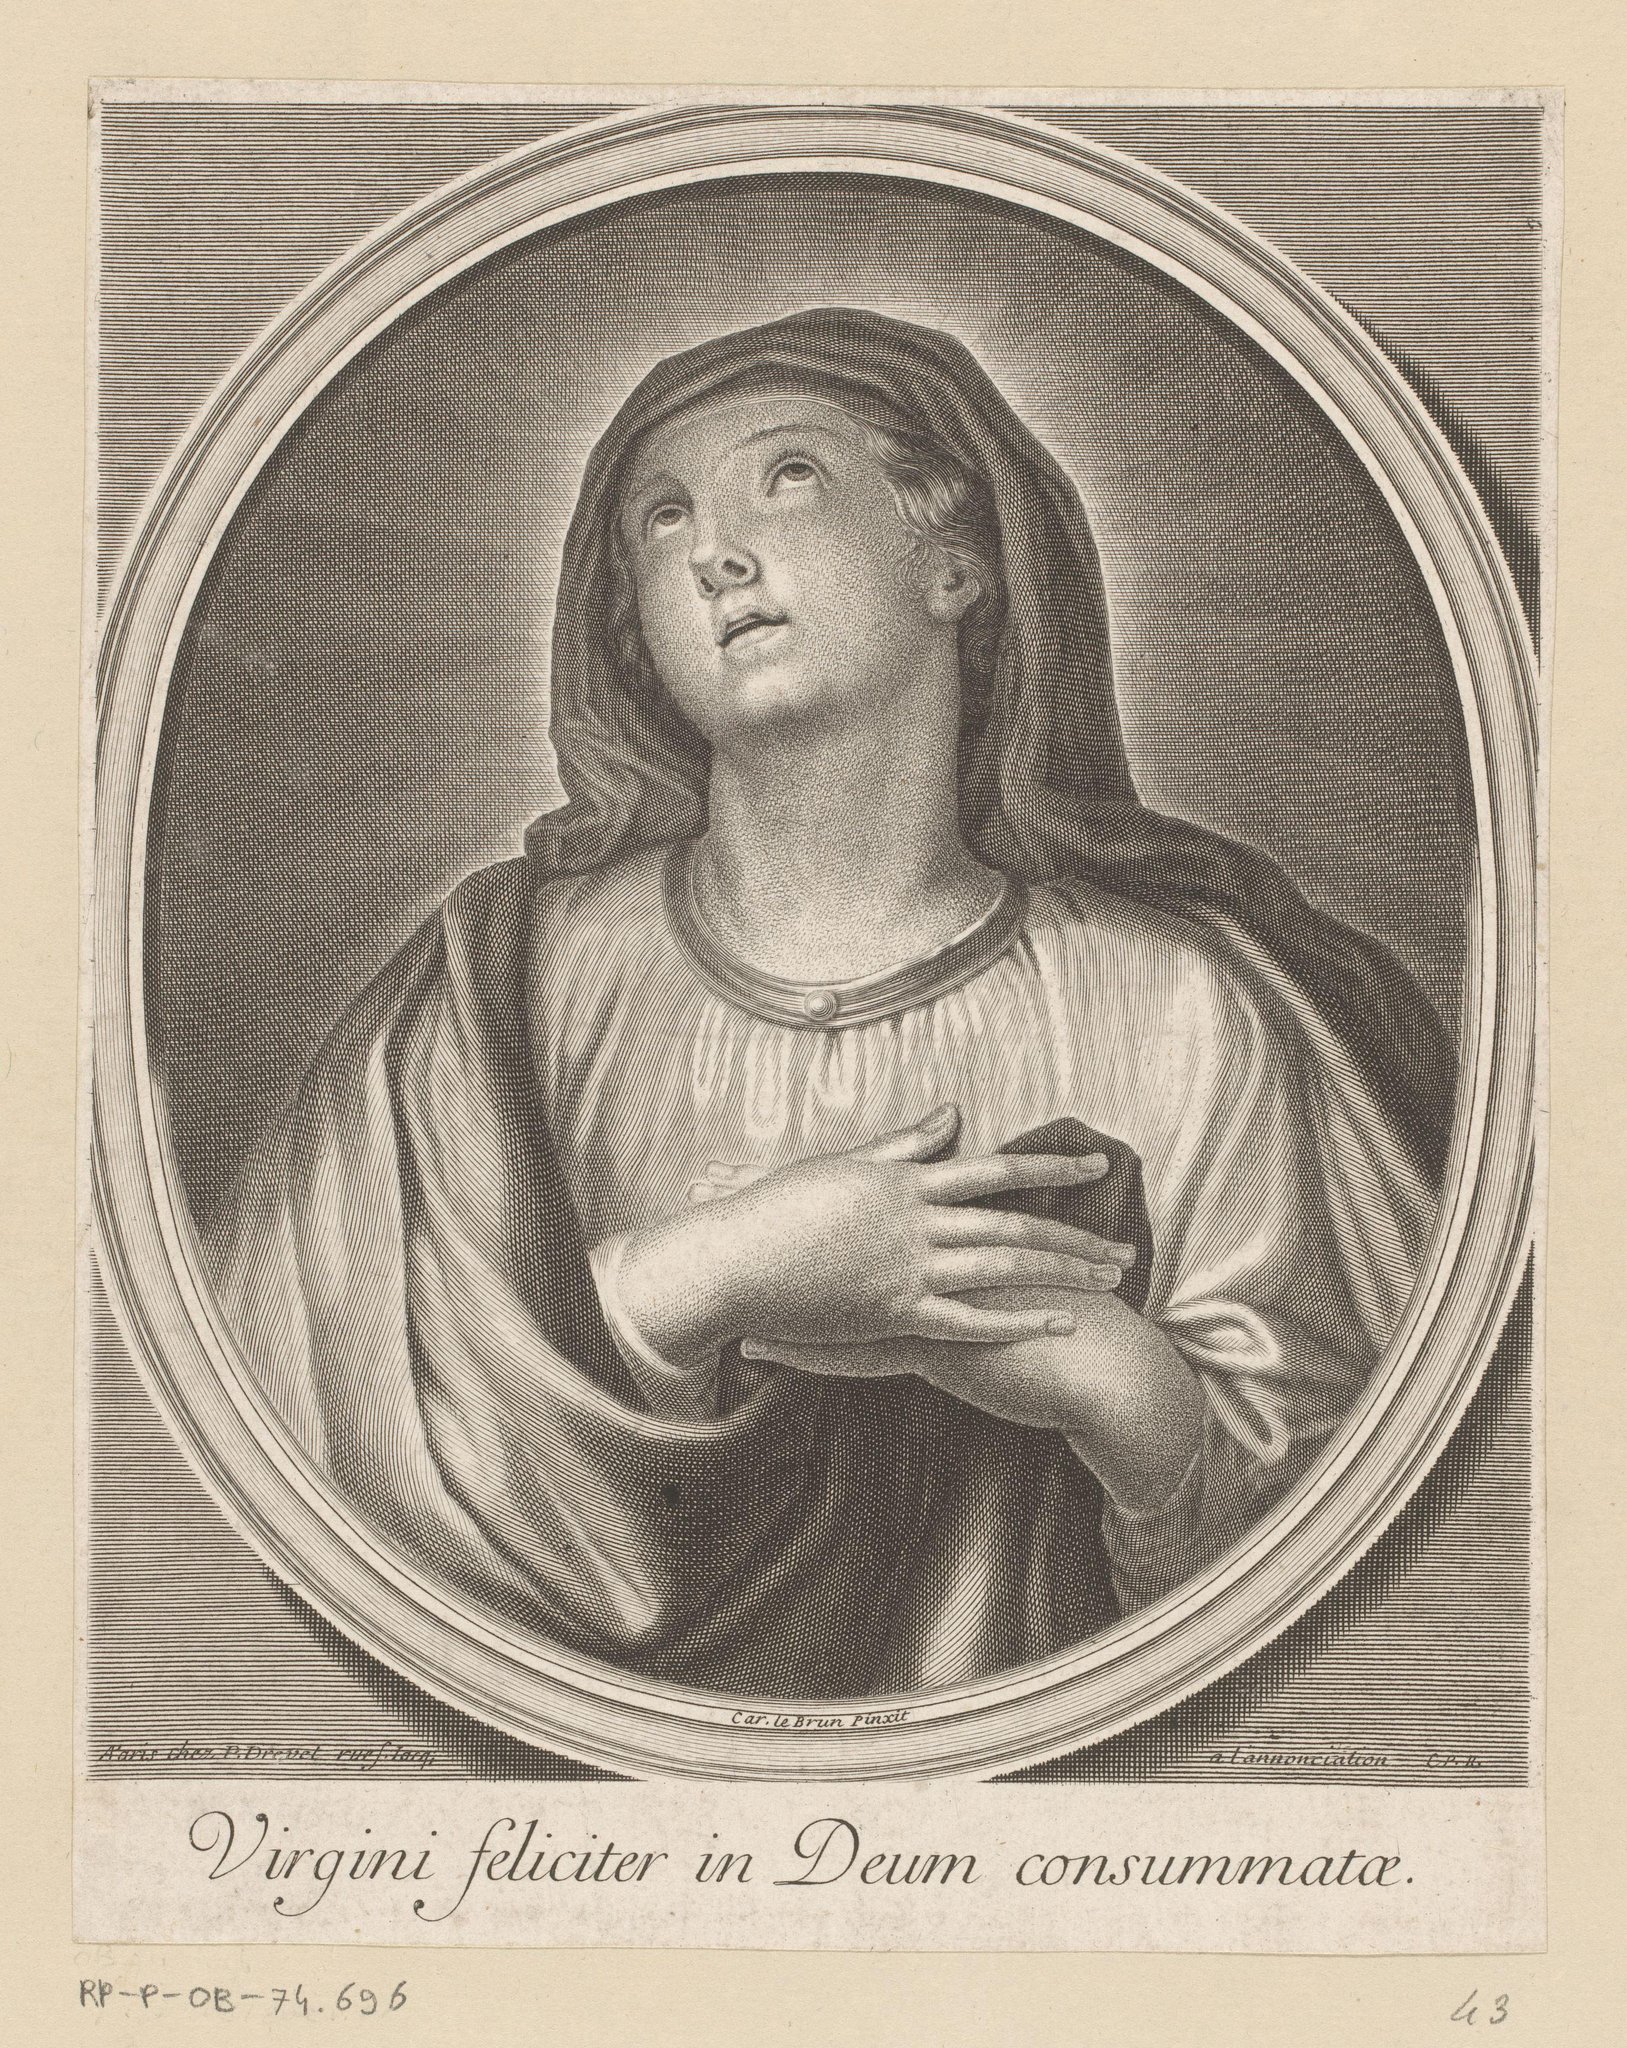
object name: print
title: Virgini feliciter in Deum consummatae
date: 1673-1738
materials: paper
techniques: engraving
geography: paris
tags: upright figures of mary without the christ-child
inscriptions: collector's mark: Lugt 240